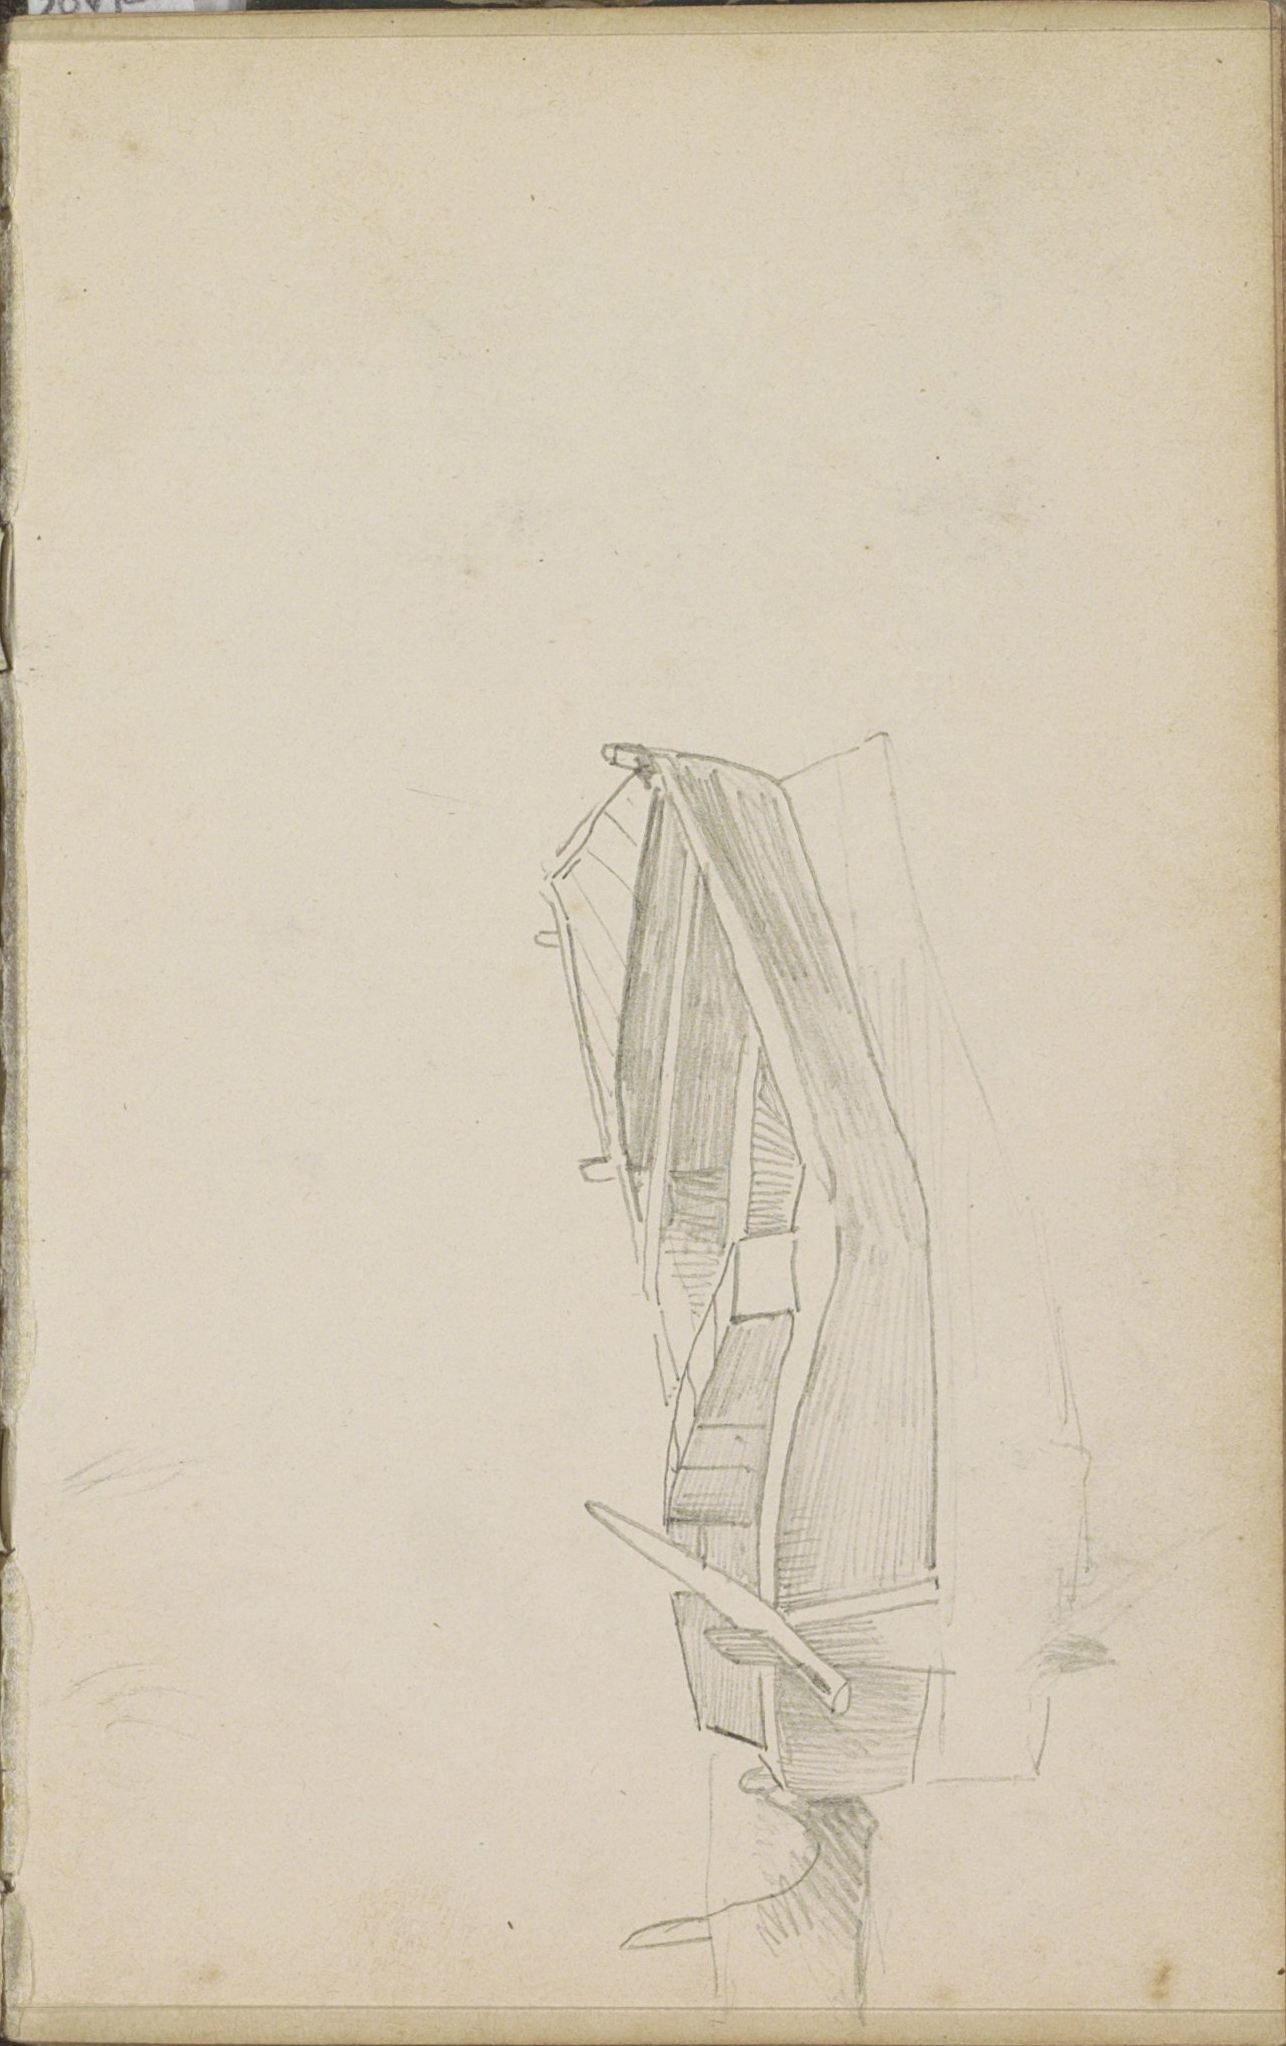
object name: sketchbook leaf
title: Houten boot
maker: johannes tavenraat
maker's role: draughtsman, painter, print maker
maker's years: 1809-1881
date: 1839-1872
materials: paper, pencil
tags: traffic on the water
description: Blad 16 recto uit een schetsboek met 73 bladen.